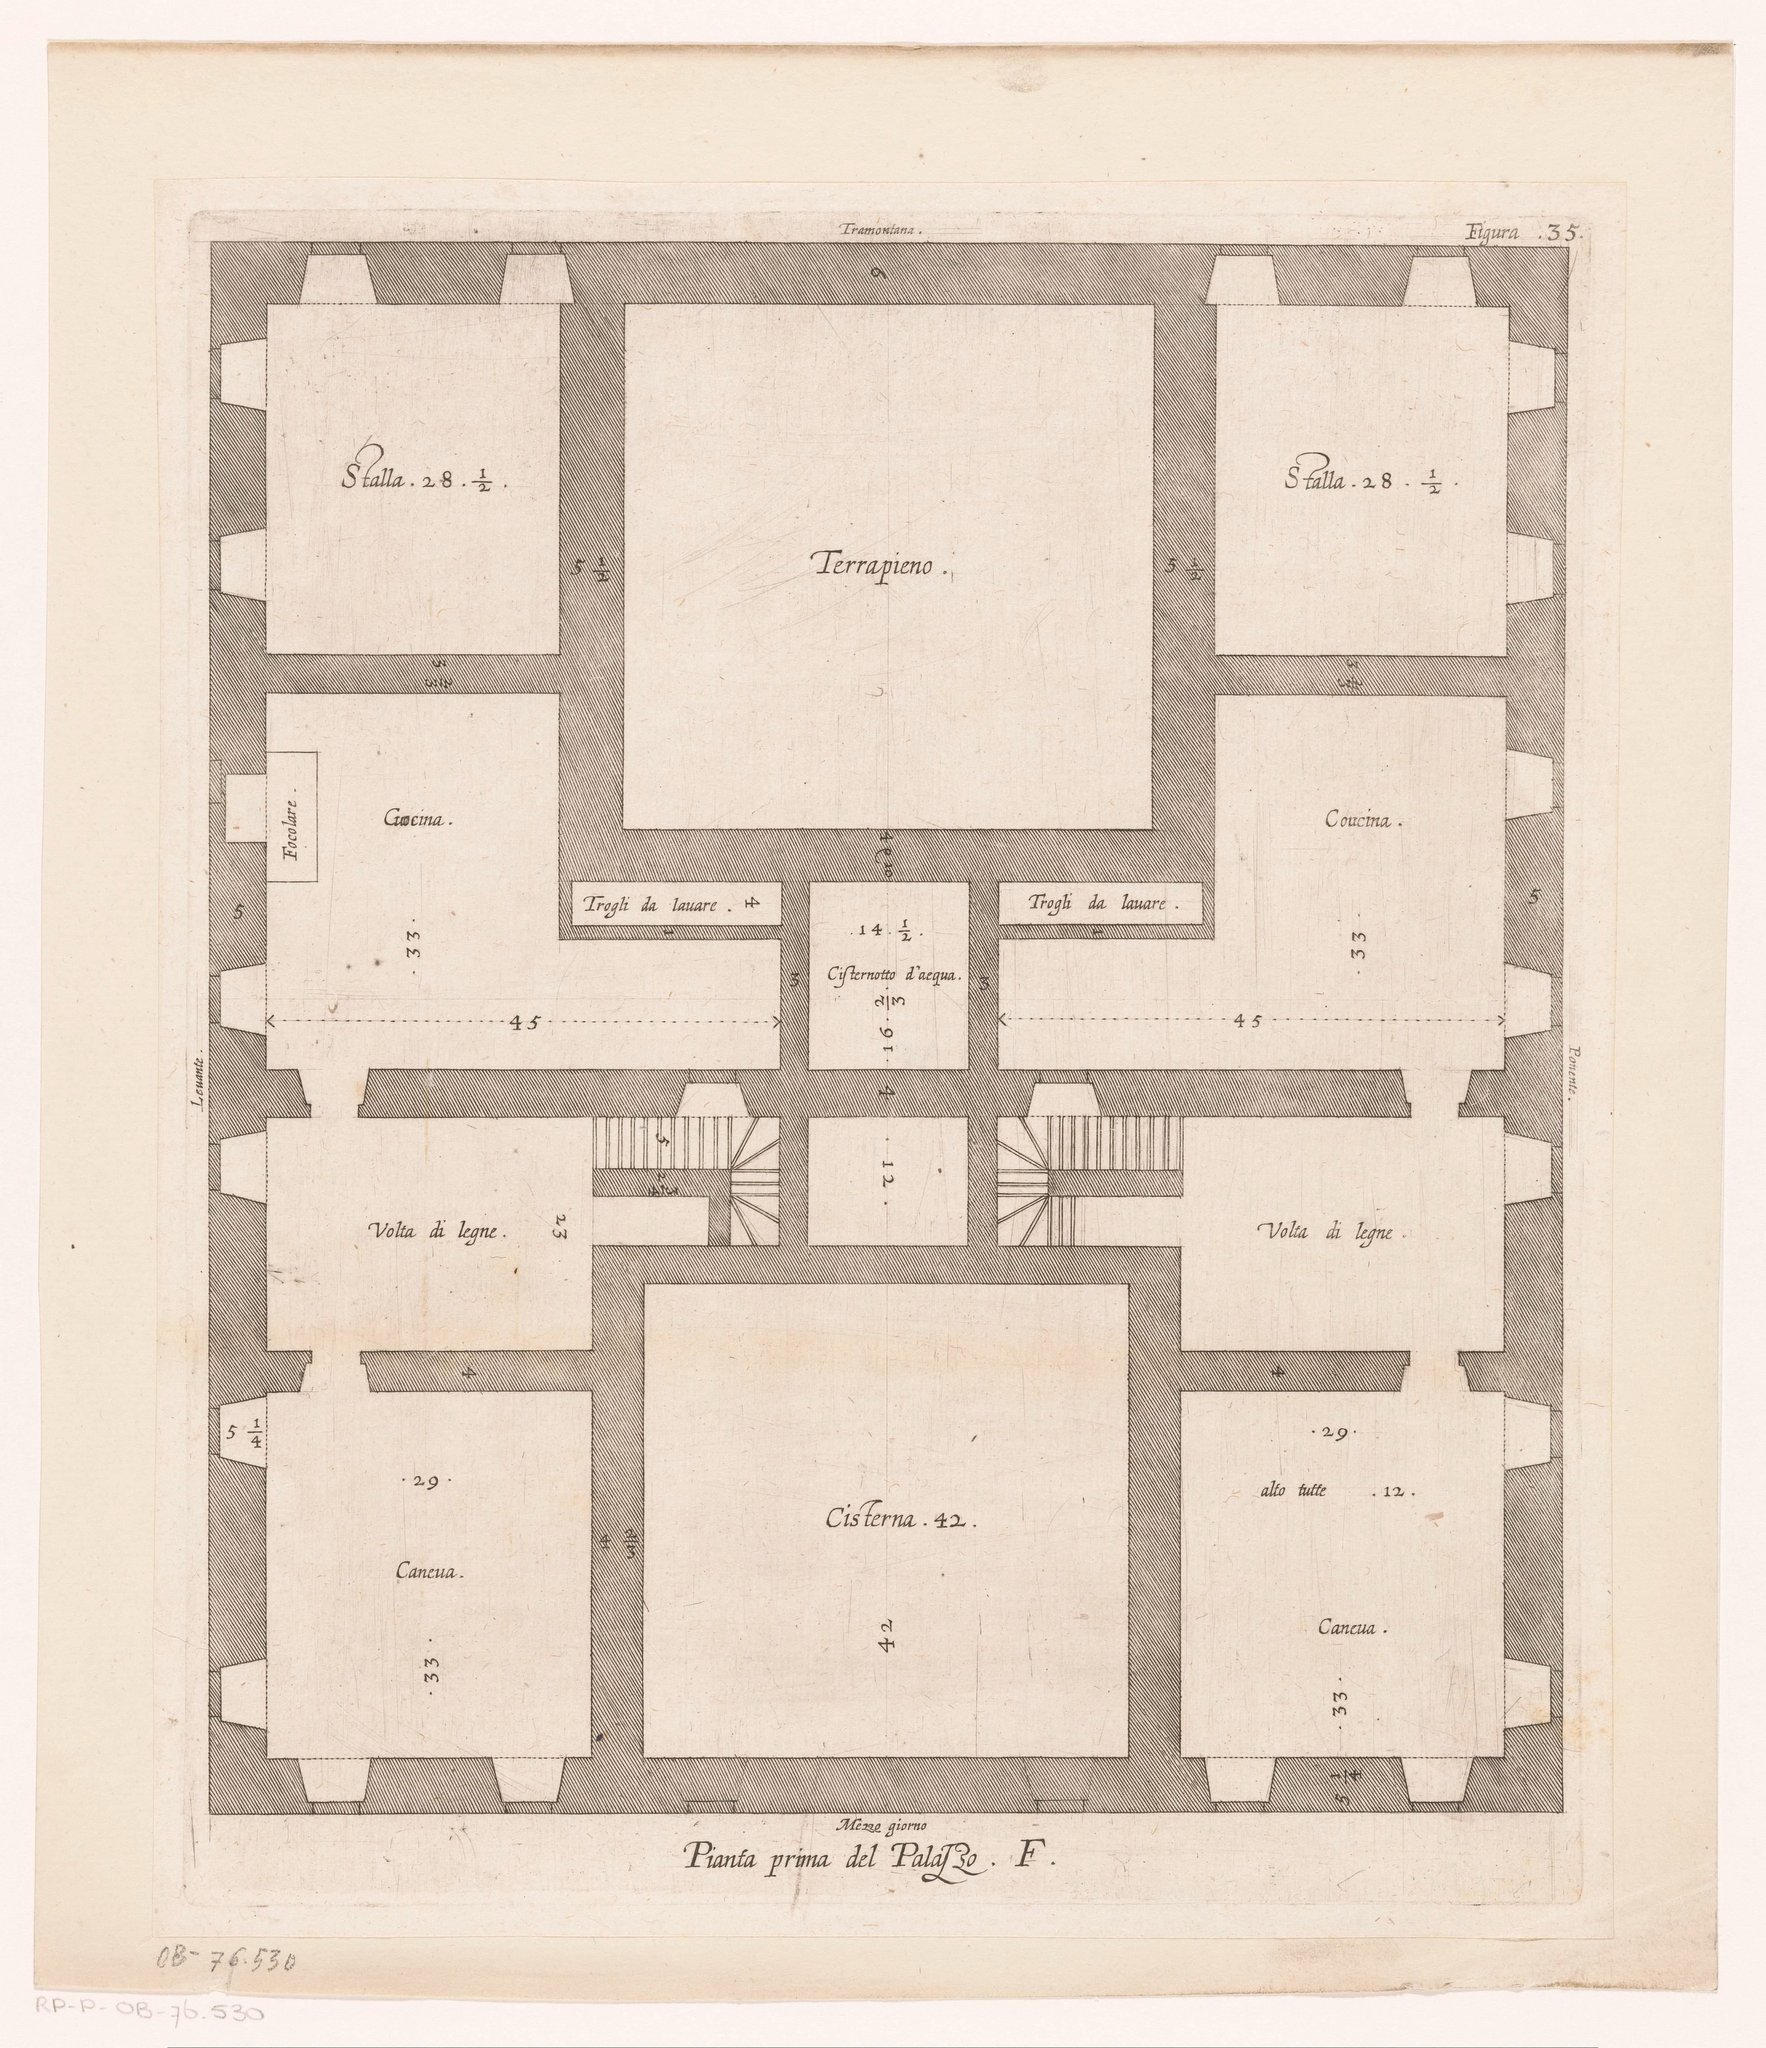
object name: print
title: Palazzi di Genova / Palazzi Antichi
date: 1622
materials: paper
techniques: engraving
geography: antwerp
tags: hôtel, i.e. small palace in city - aa - civic architecture: inside, plan ~ architecture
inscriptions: collector's mark: Lugt 240